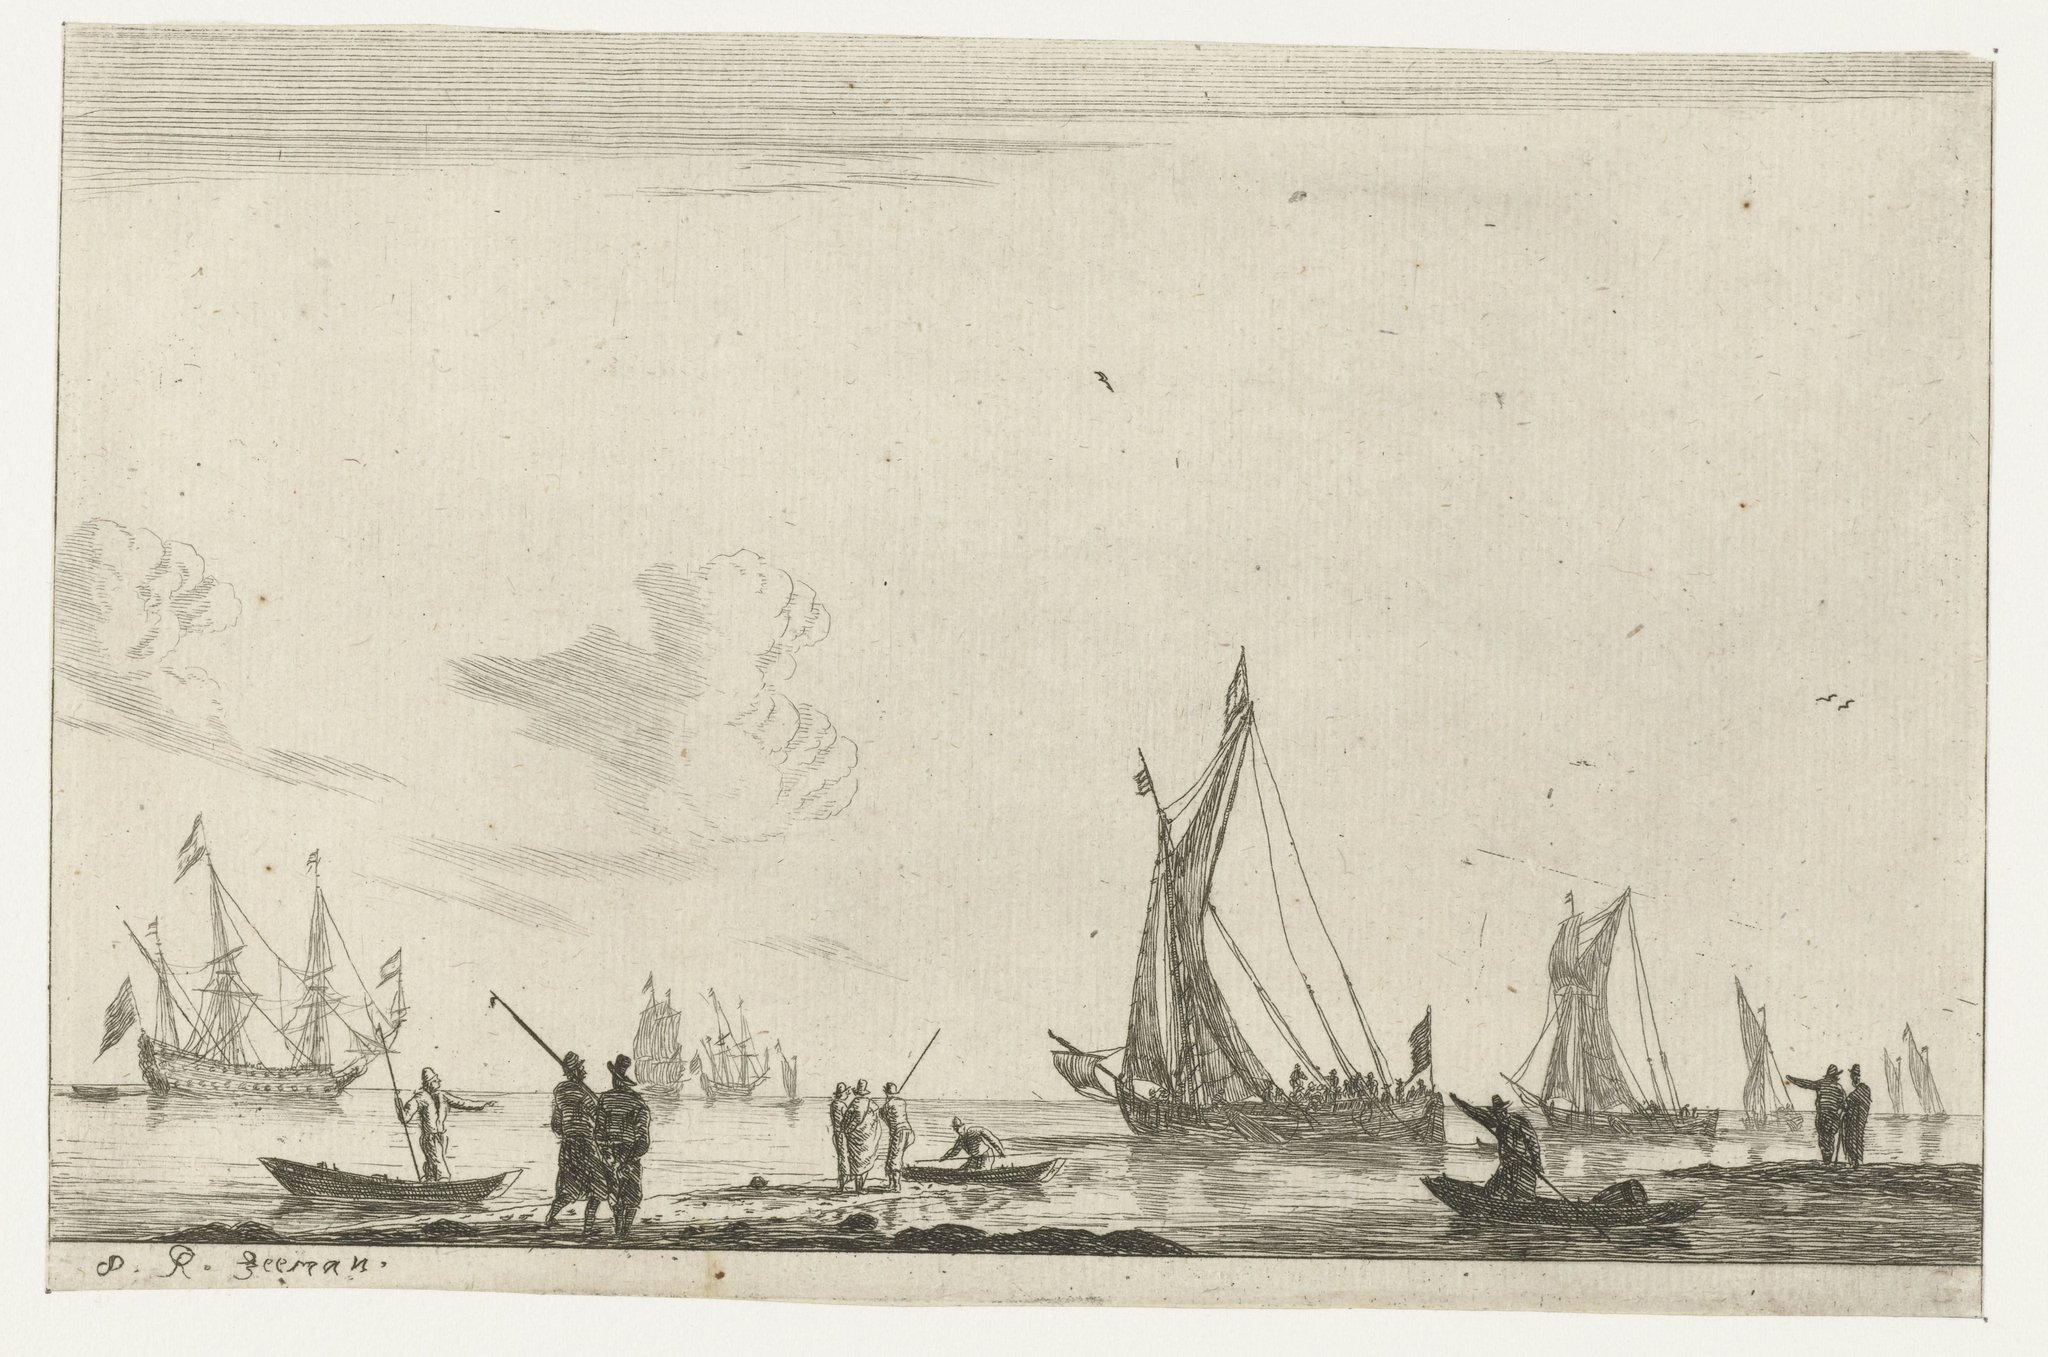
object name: print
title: Binnenwateren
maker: reinier nooms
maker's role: draughtsman, painter, print maker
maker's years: 1623-1664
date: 1654-1658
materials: paper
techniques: etching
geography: netherlands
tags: sailing-ship, sailing-boat, water course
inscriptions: collector's mark: Lugt 1120, collector's mark: Lugt 12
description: Groot binnenwater met een aantal zeilschepen, links een koopvaardijschip. Op de voorgrond een aantal mensen staand op de oever en drie kleine bootjes.